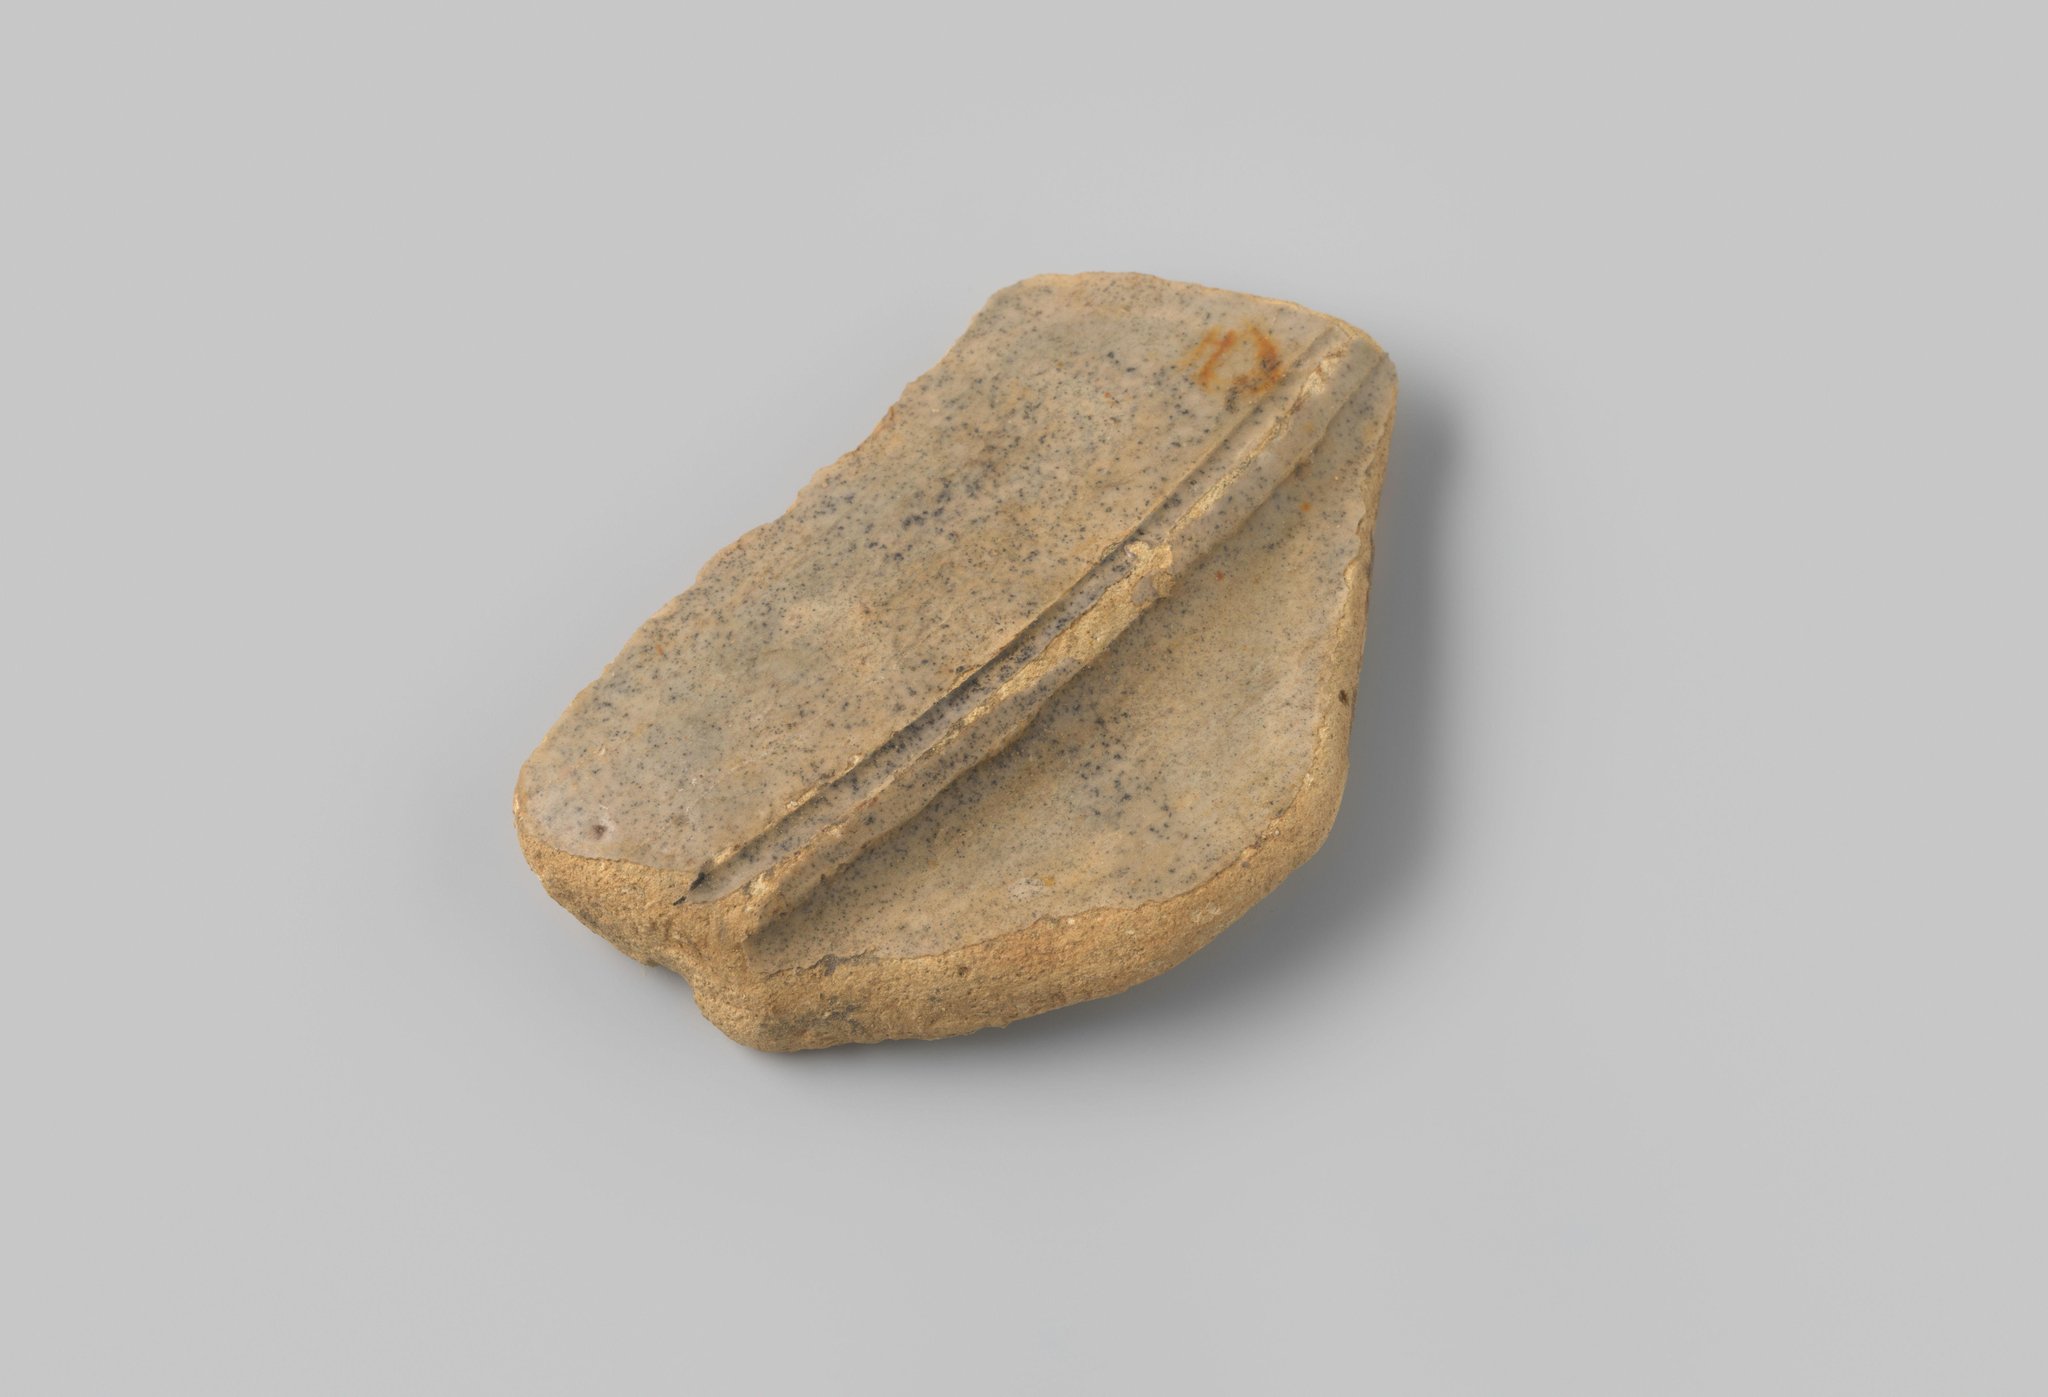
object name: plate dish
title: Scherf van een bord uit het wrak van de Oost-Indiëvaarder Hollandia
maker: Anonymous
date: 1700-1743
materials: faience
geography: netherlands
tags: verenigde oostindische compagnie, hollandia (schip), annet